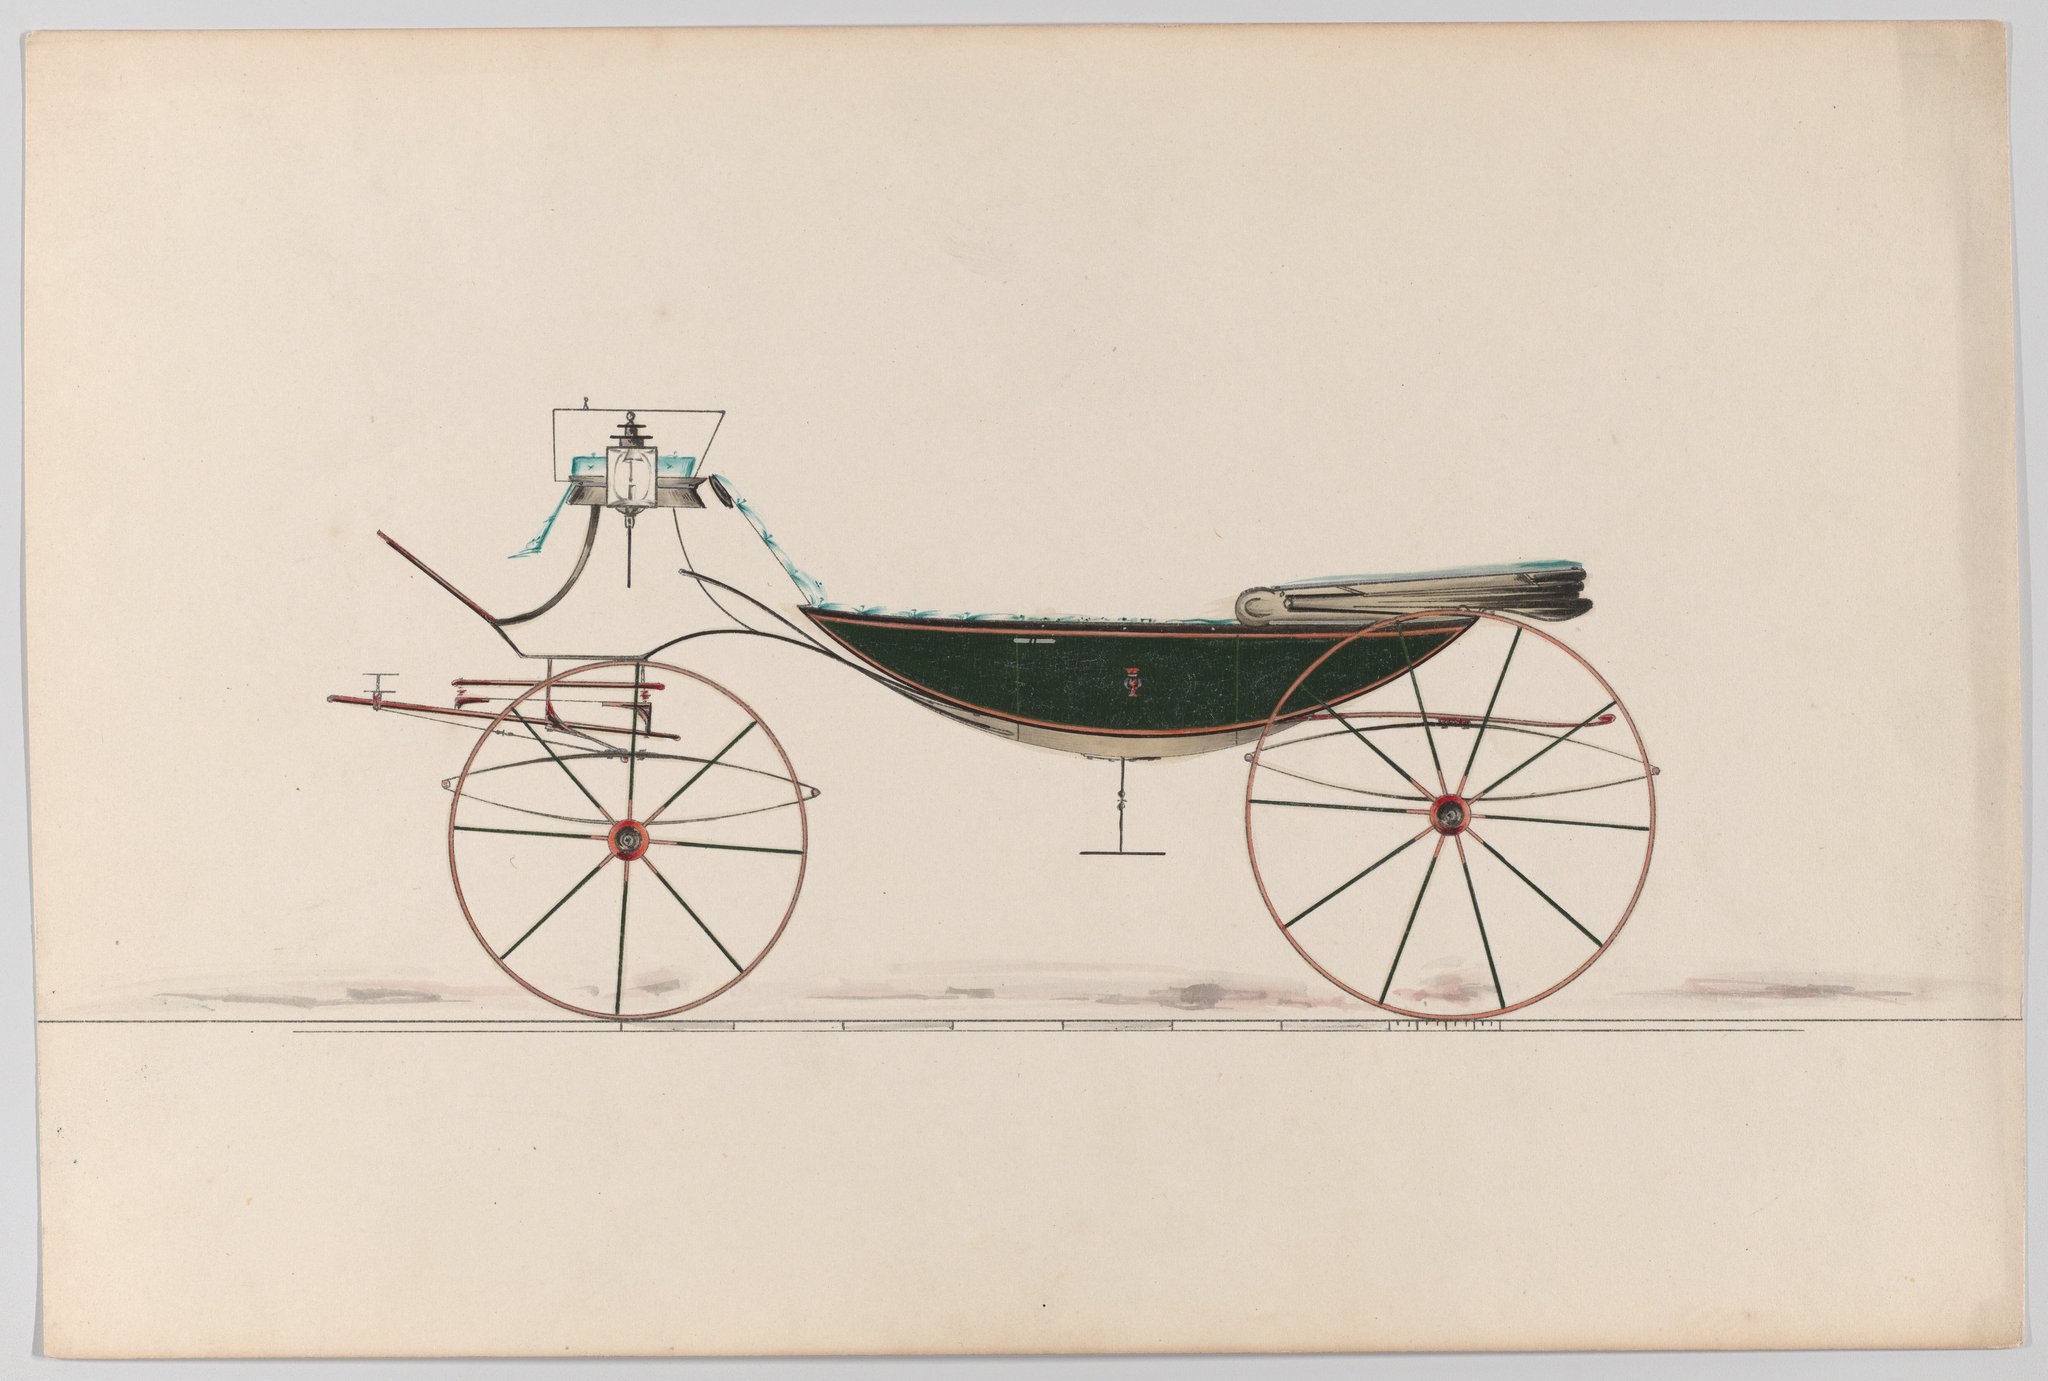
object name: drawing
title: Design for Vis-à-vis with Canoe Bottom (unnumbered)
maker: brewster & co.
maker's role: manufacturer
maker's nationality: american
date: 1870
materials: gouache, gum arabic, ink, watercolor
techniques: pen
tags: carriages